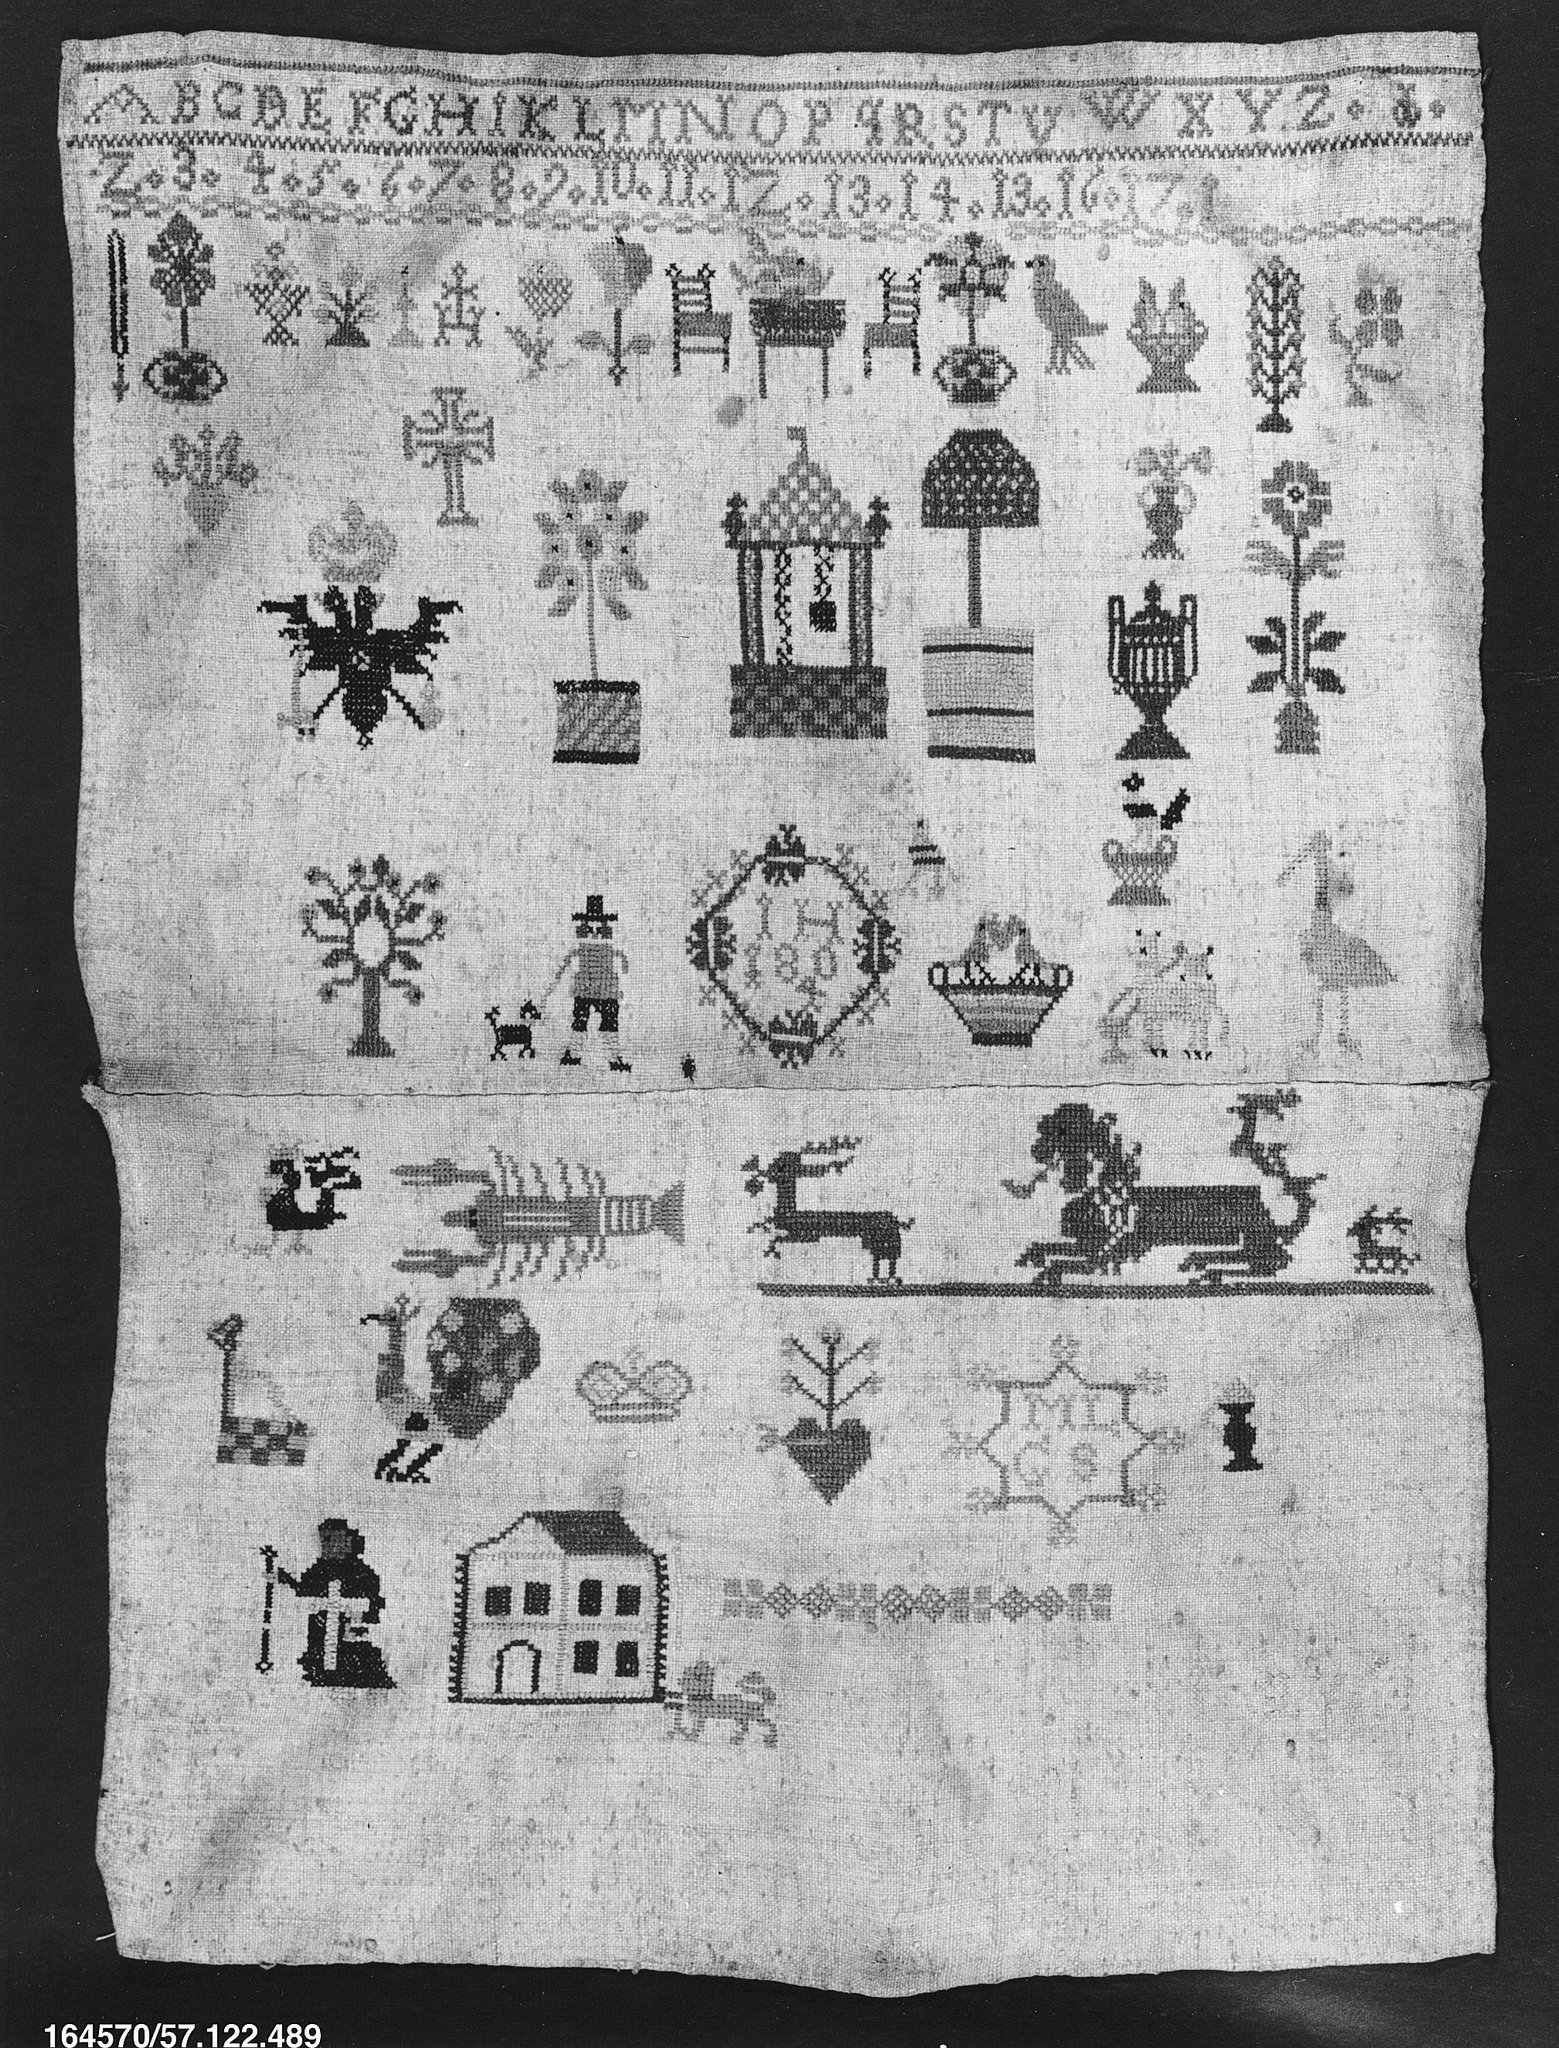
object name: sampler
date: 1804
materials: linen, silk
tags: human figures,animals,birds